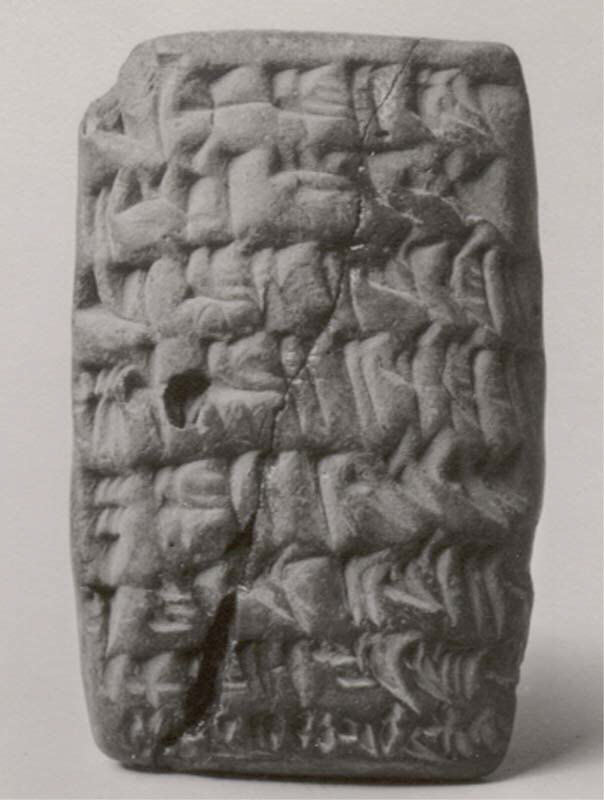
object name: cuneiform tablet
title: Cuneiform tablet: record of silver for purchase of animals, Ebabbar archive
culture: babylonian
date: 700-501 BCE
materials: clay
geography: mesopotamia